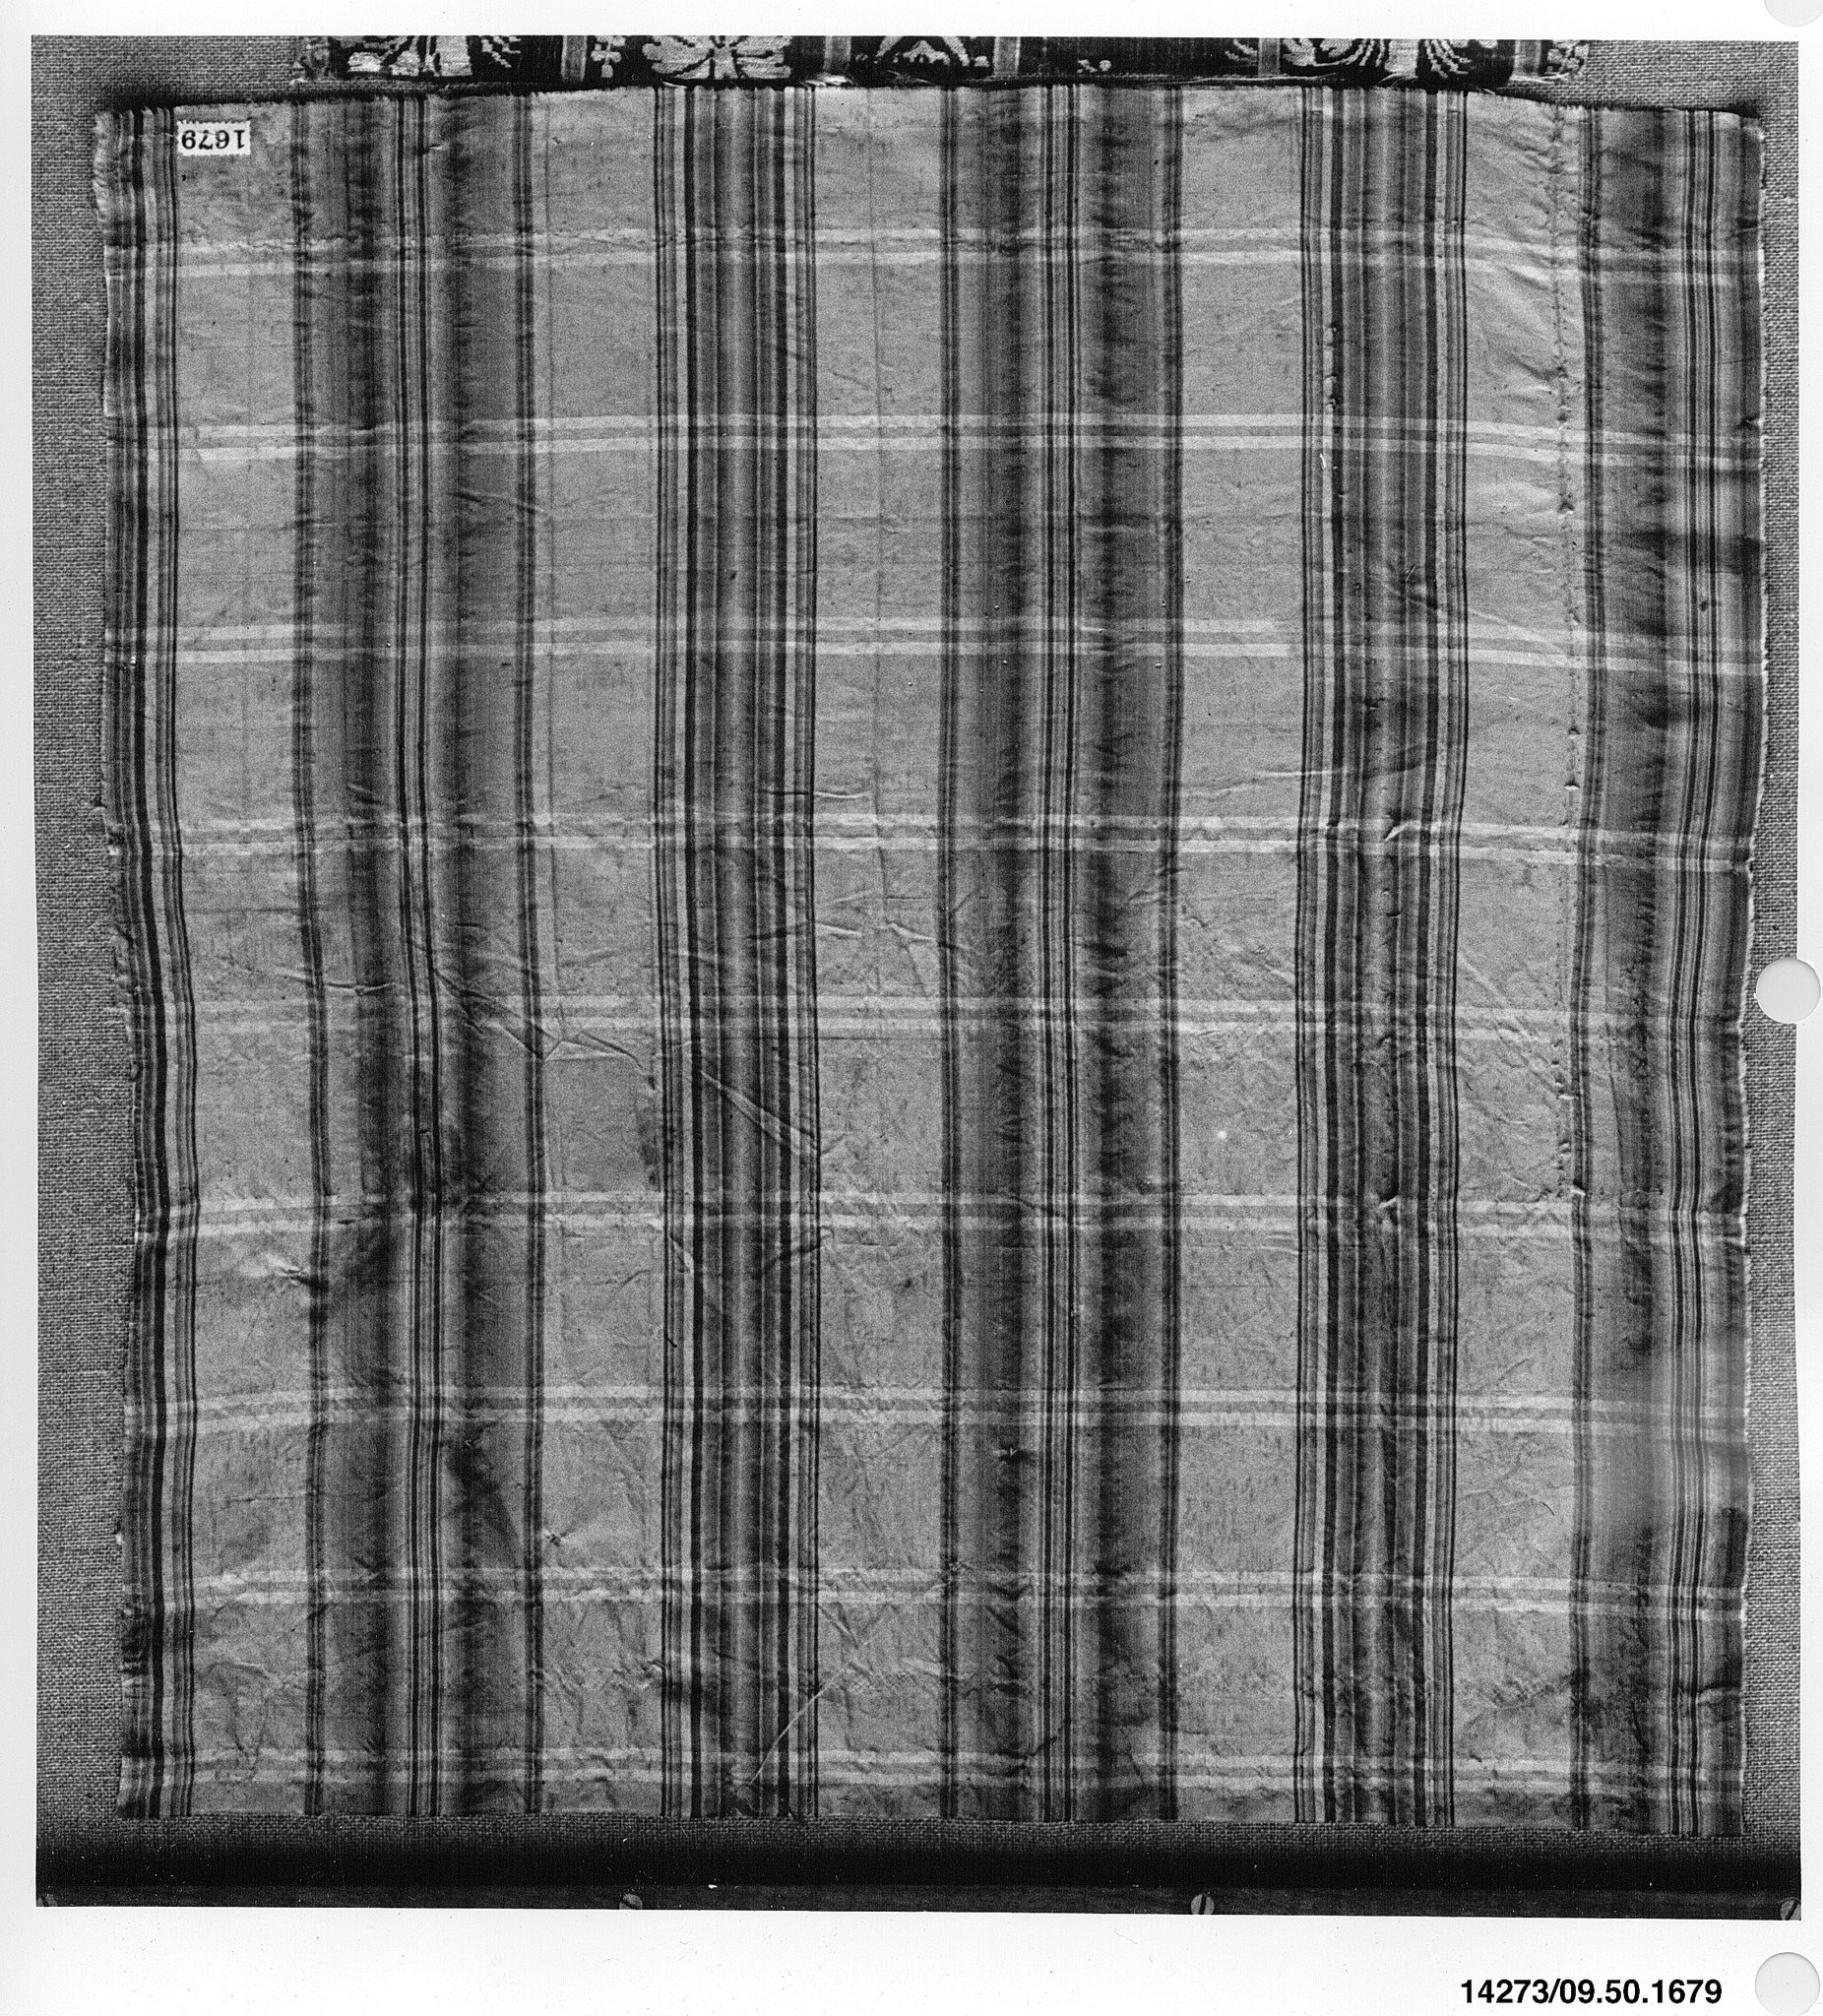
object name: piece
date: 1701-1800